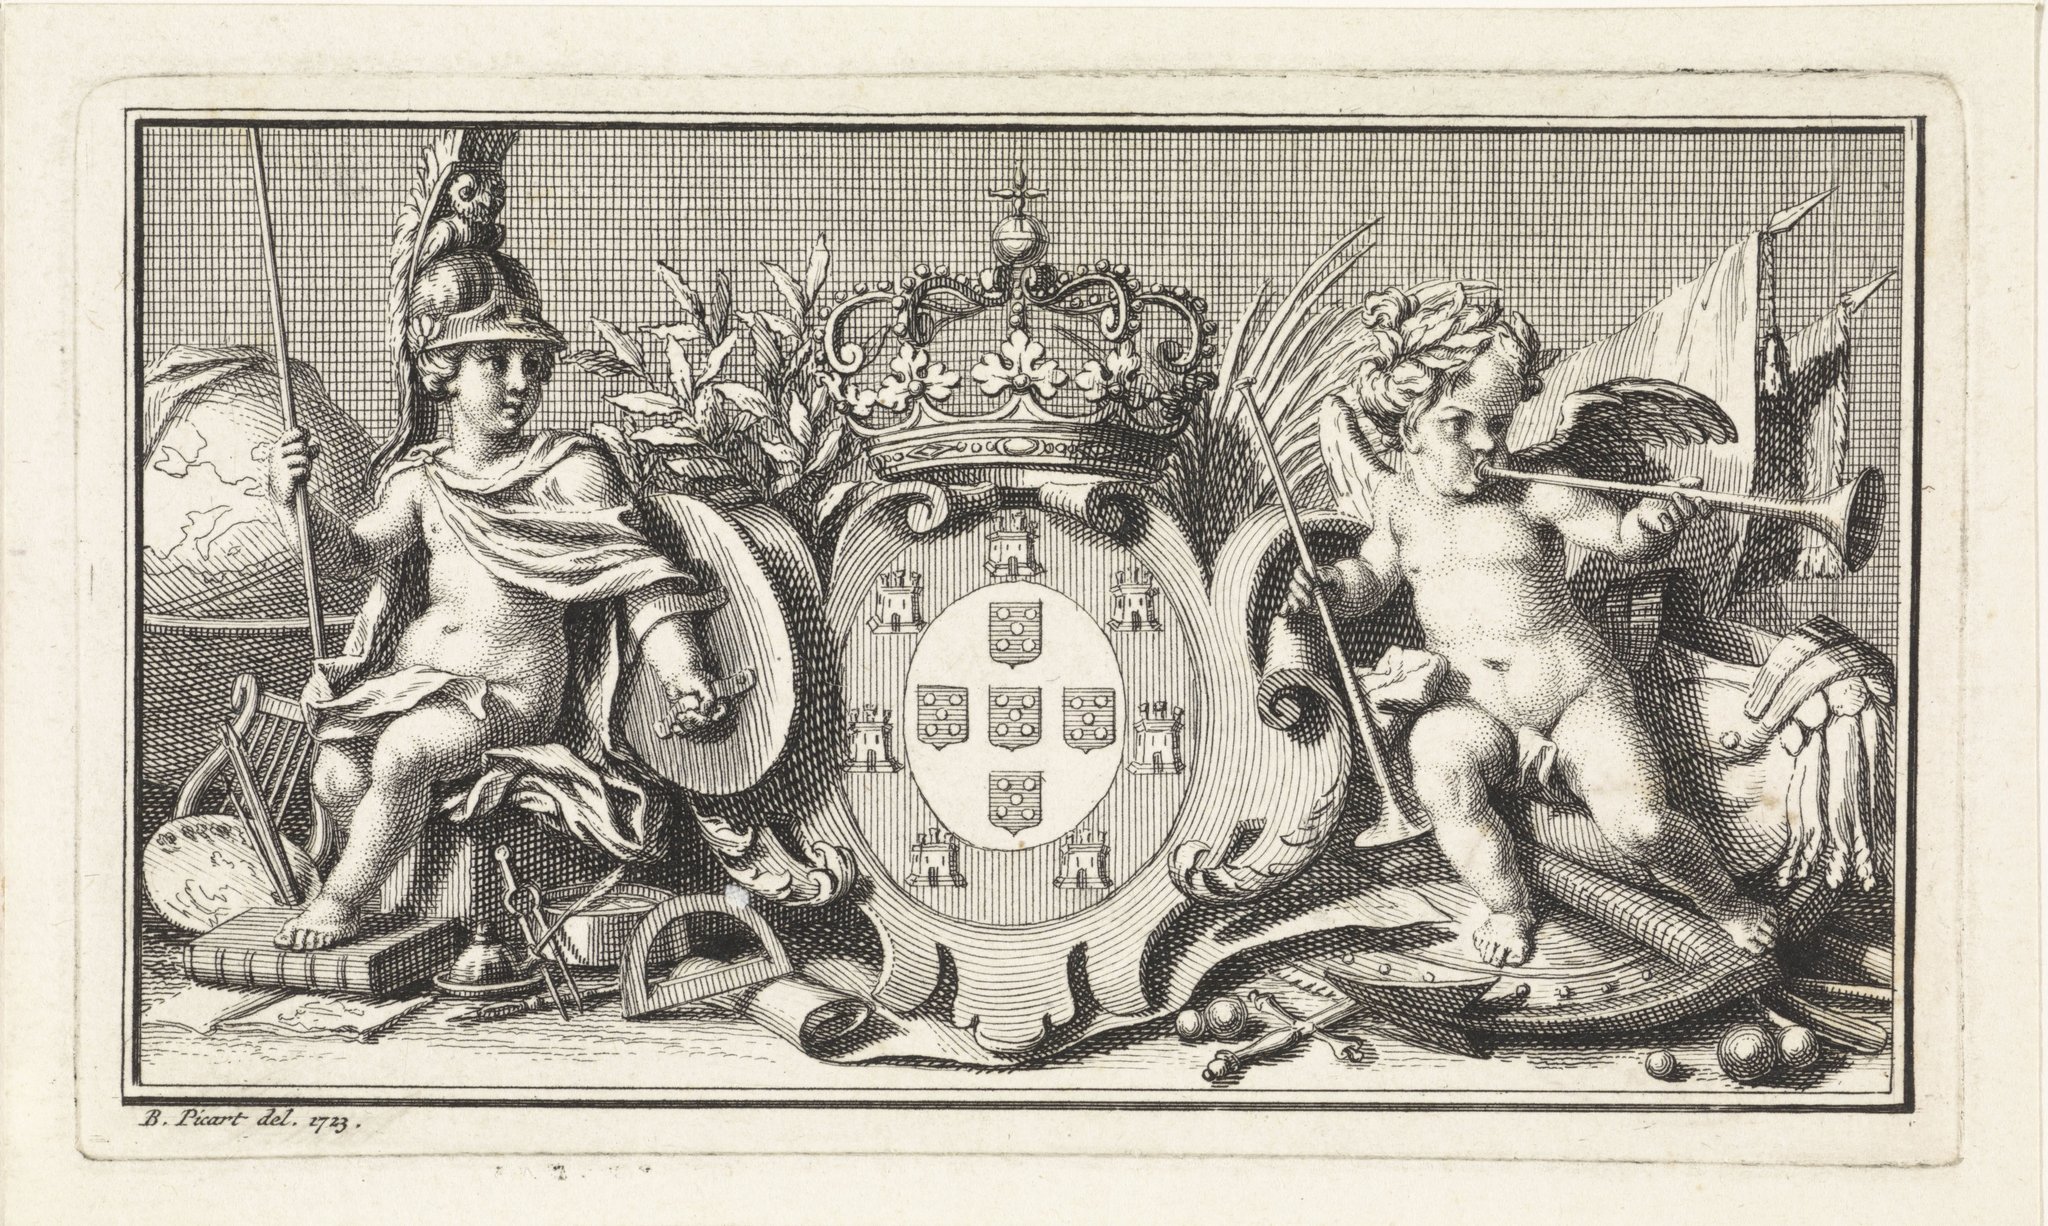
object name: print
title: Wapenschild van Portugal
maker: bernard picart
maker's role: draughtsman, print maker, publisher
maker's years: 1673-1733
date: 1723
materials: paper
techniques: engraving, etching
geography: amsterdam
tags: coat of arms (as symbol of the state, etc.), (story of) minerva (pallas, athena), fame; 'fama', 'fama buona', 'fama chiara' (ripa)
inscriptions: collector's mark: Lugt 240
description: Het wapenschild van Portugal geflankeerd door twee putti, waarvan de een als Minerva en de ander als Faam.